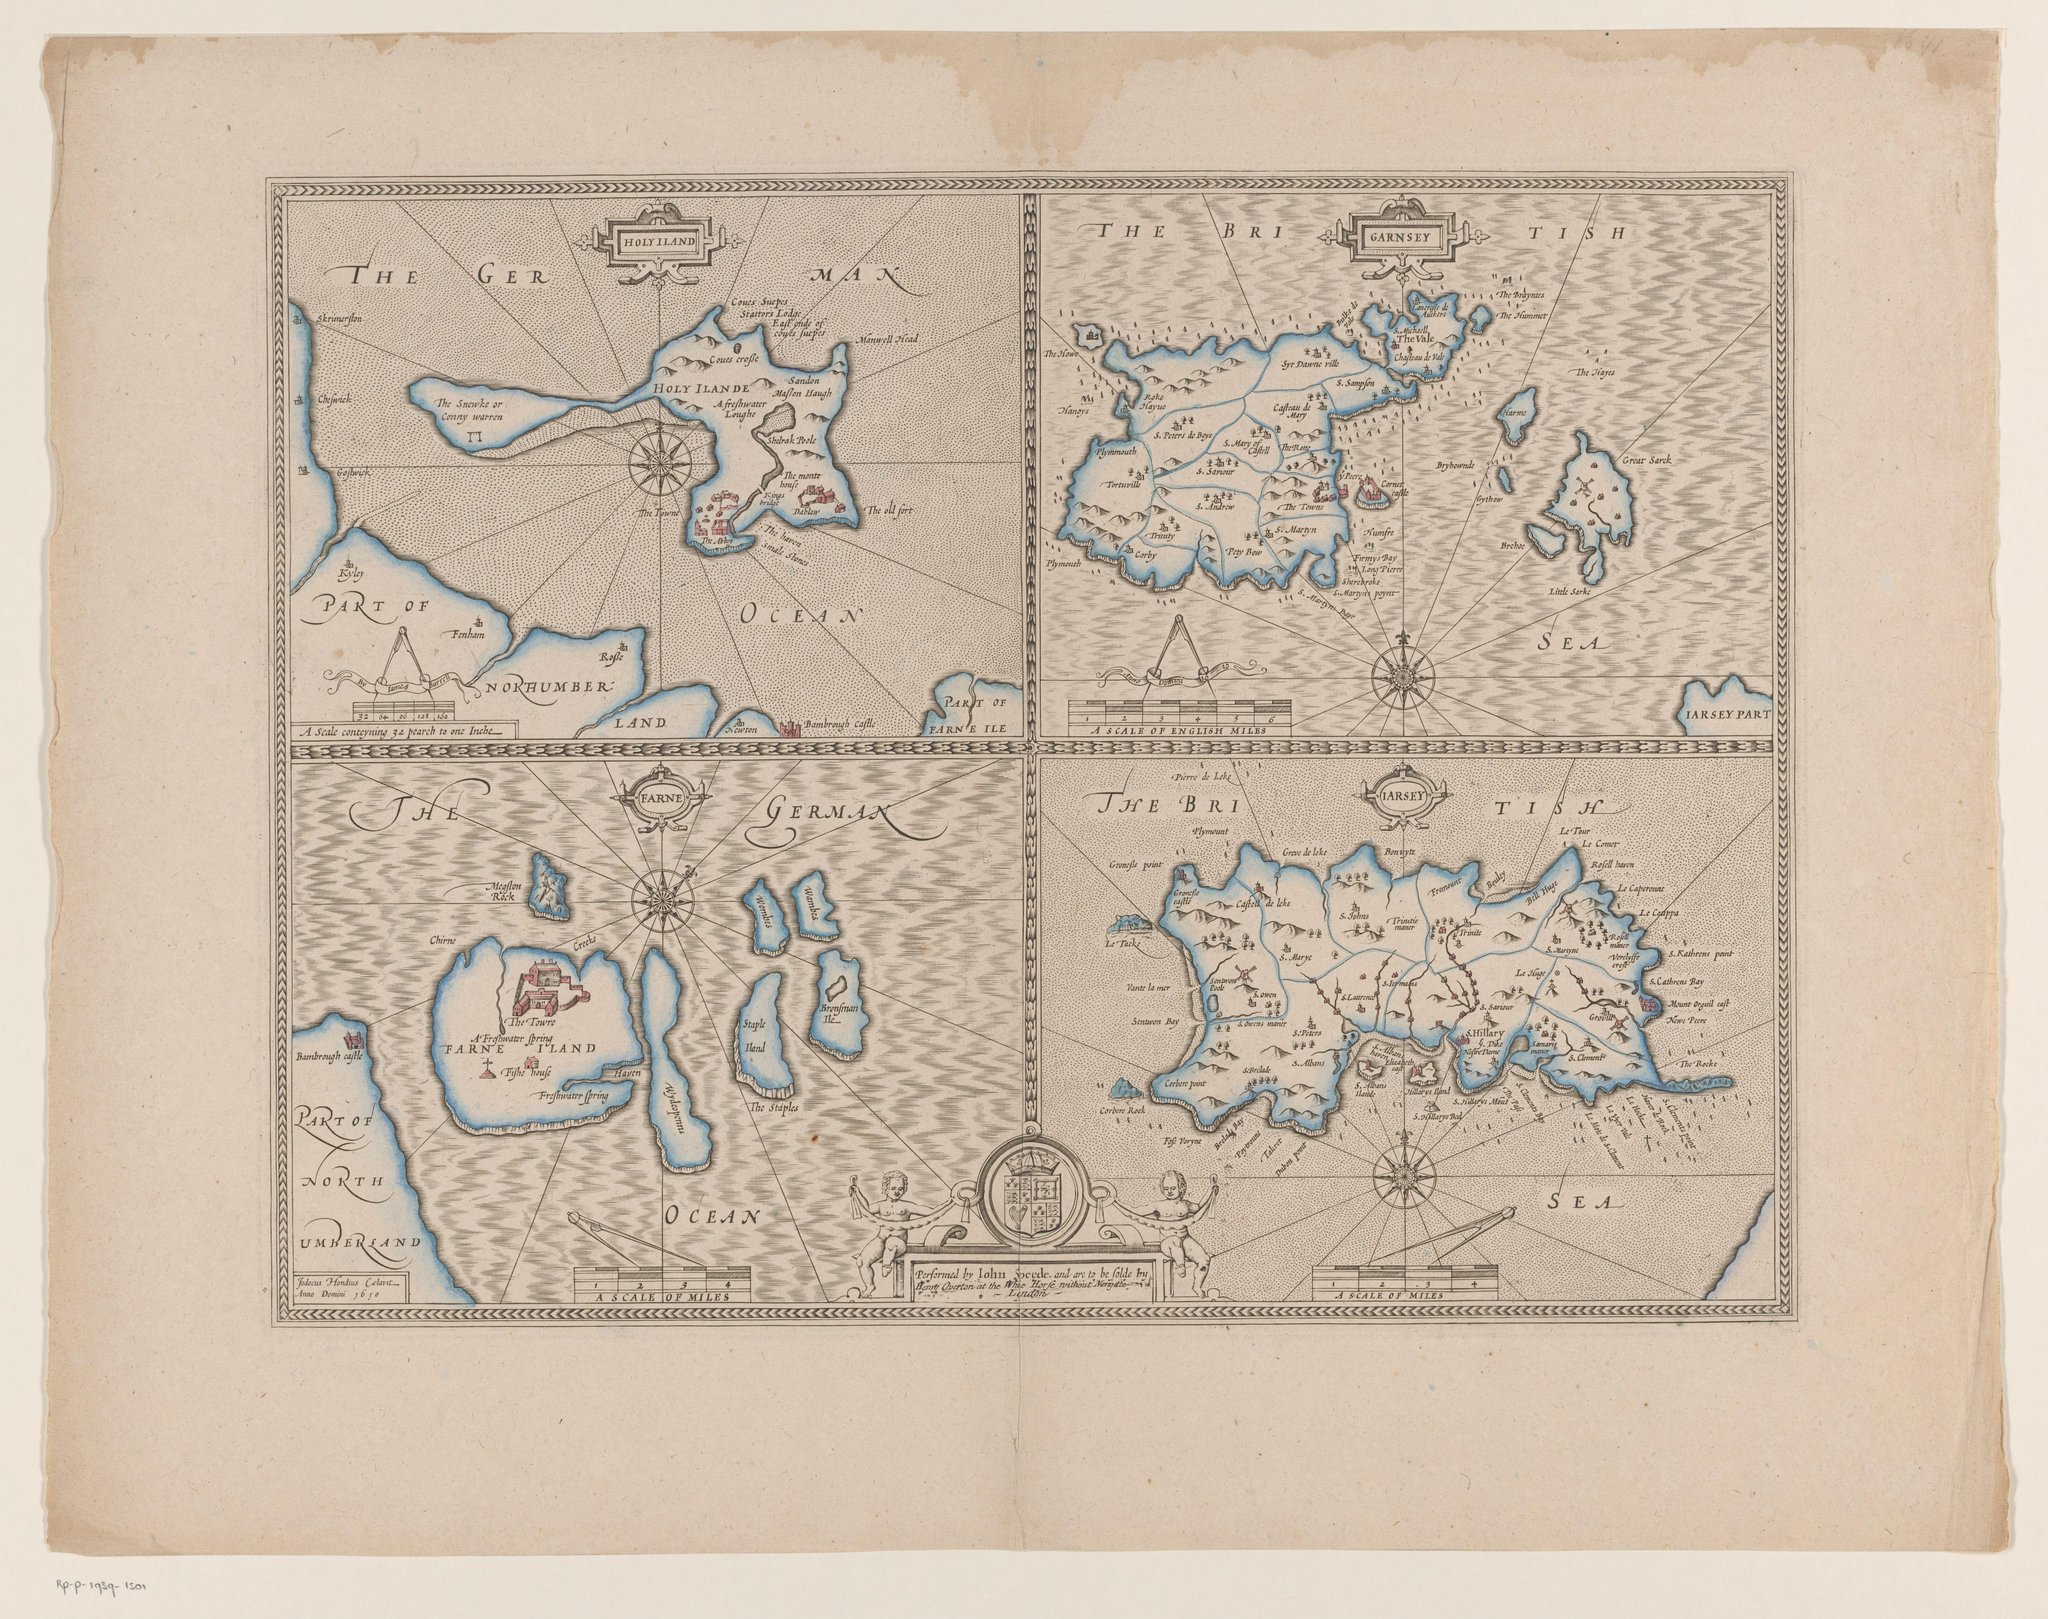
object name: print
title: Holy Island / Garnsey / Jarsey / Farne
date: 1710-1751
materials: paper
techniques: engraving, hand coloring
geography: london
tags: maps of separate countries or regions, armorial bearing, heraldry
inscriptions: collector's mark: Lugt 2166, collector's mark: Lugt 2760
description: Prent ook gebruikt in Henry Overton's editie van John Speeds atlas 'England Fully Described in a Compleat Sett of Mapps of Ye County's of England and Wales (...)'. Deze atlas is in ieder geval uitgegeven tussen 1710 en 1743.